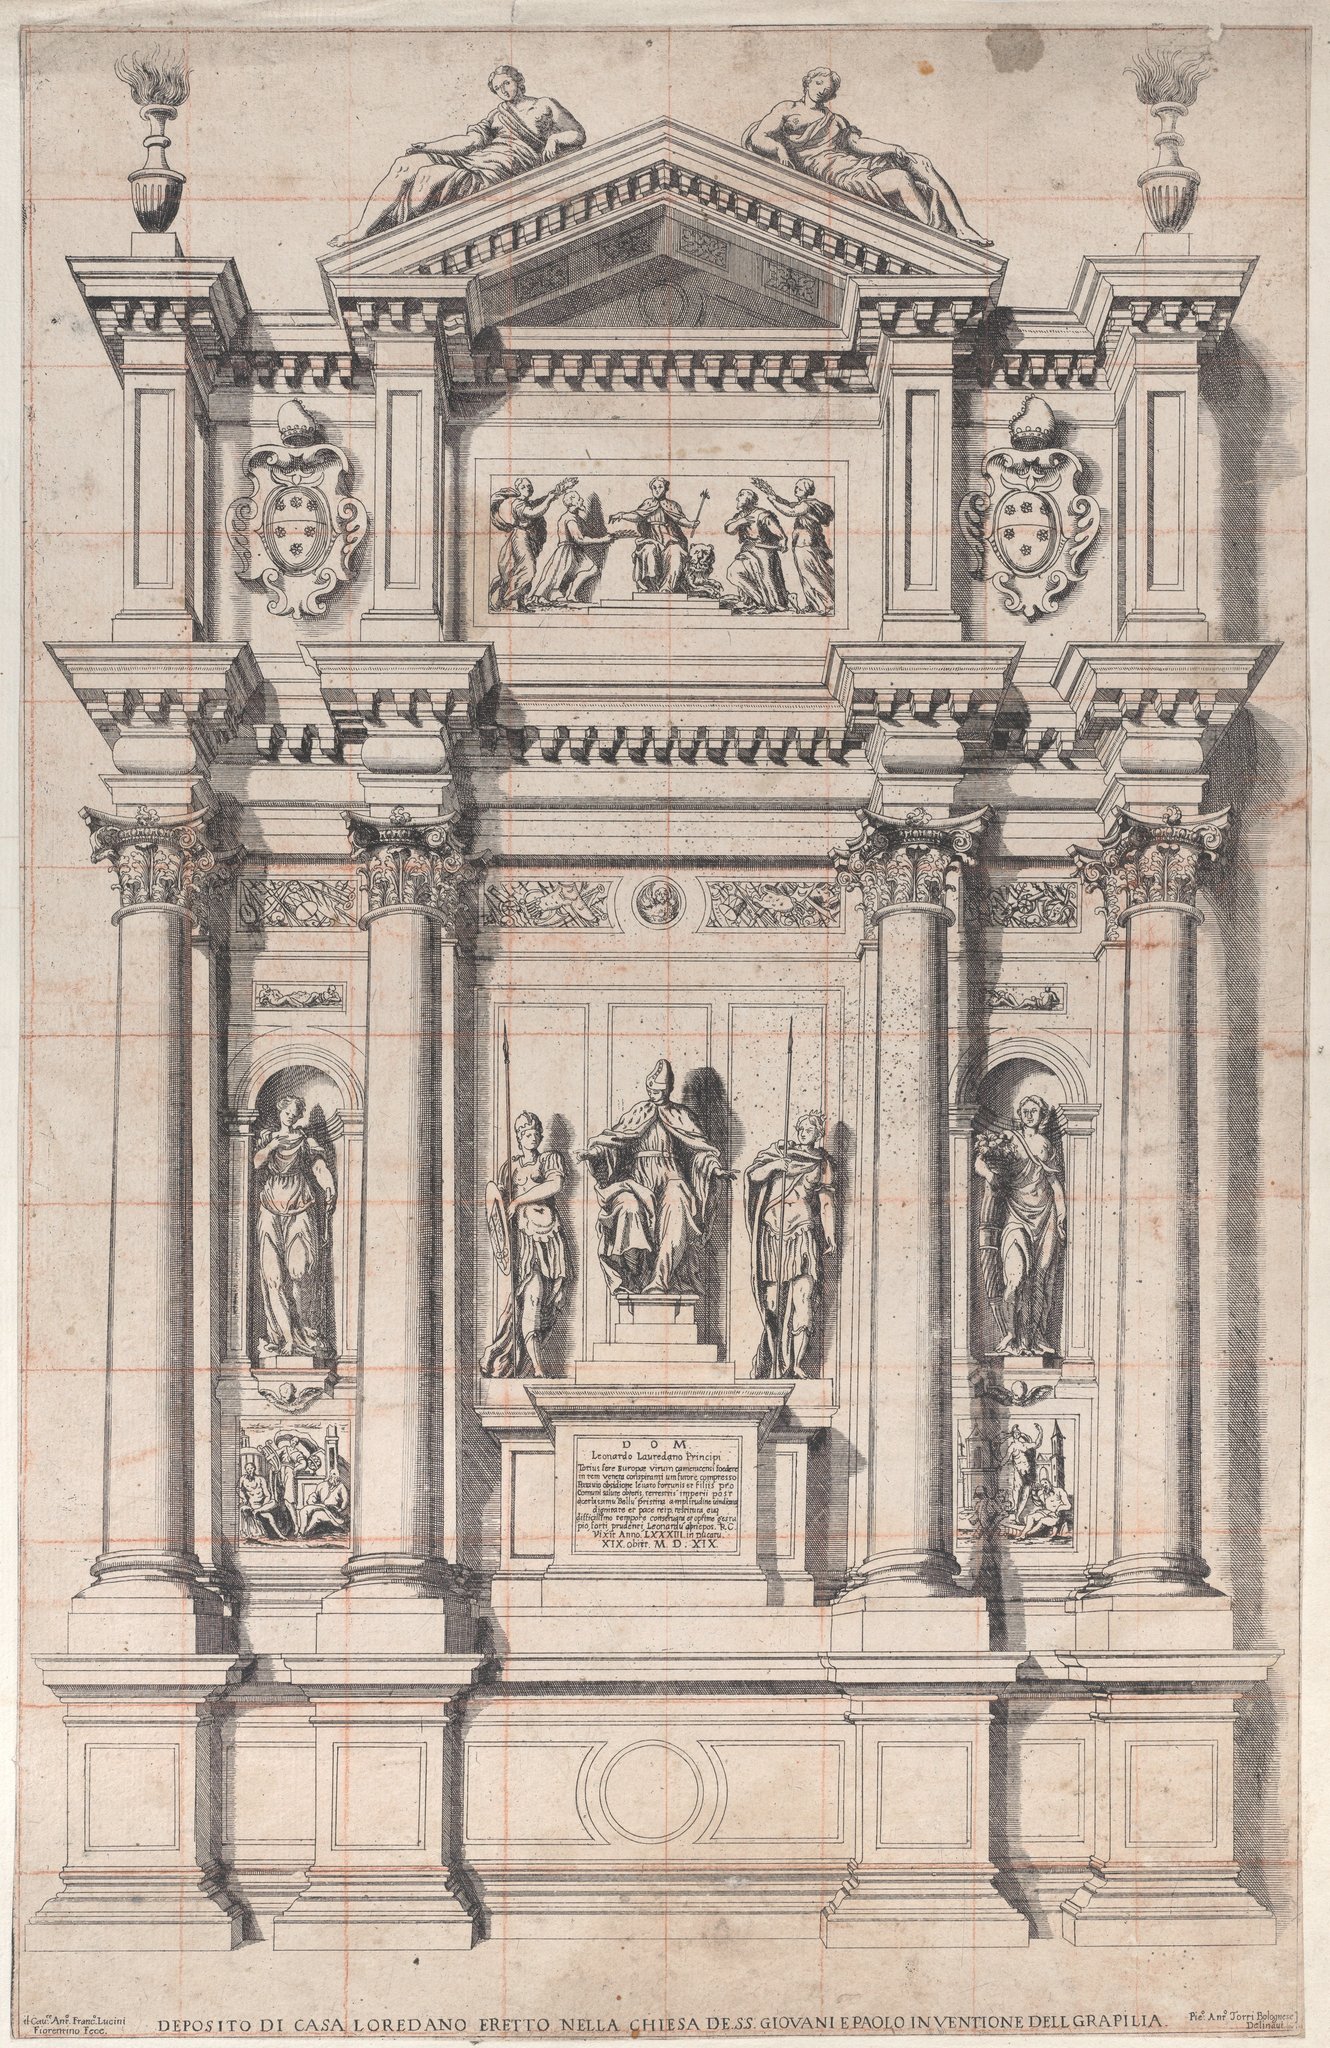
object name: print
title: Design after the monument of Leonardo Loredano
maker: antonio francesco luccini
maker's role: artist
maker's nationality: italian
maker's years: 1605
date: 1625-1700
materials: chalk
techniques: etching, drawing